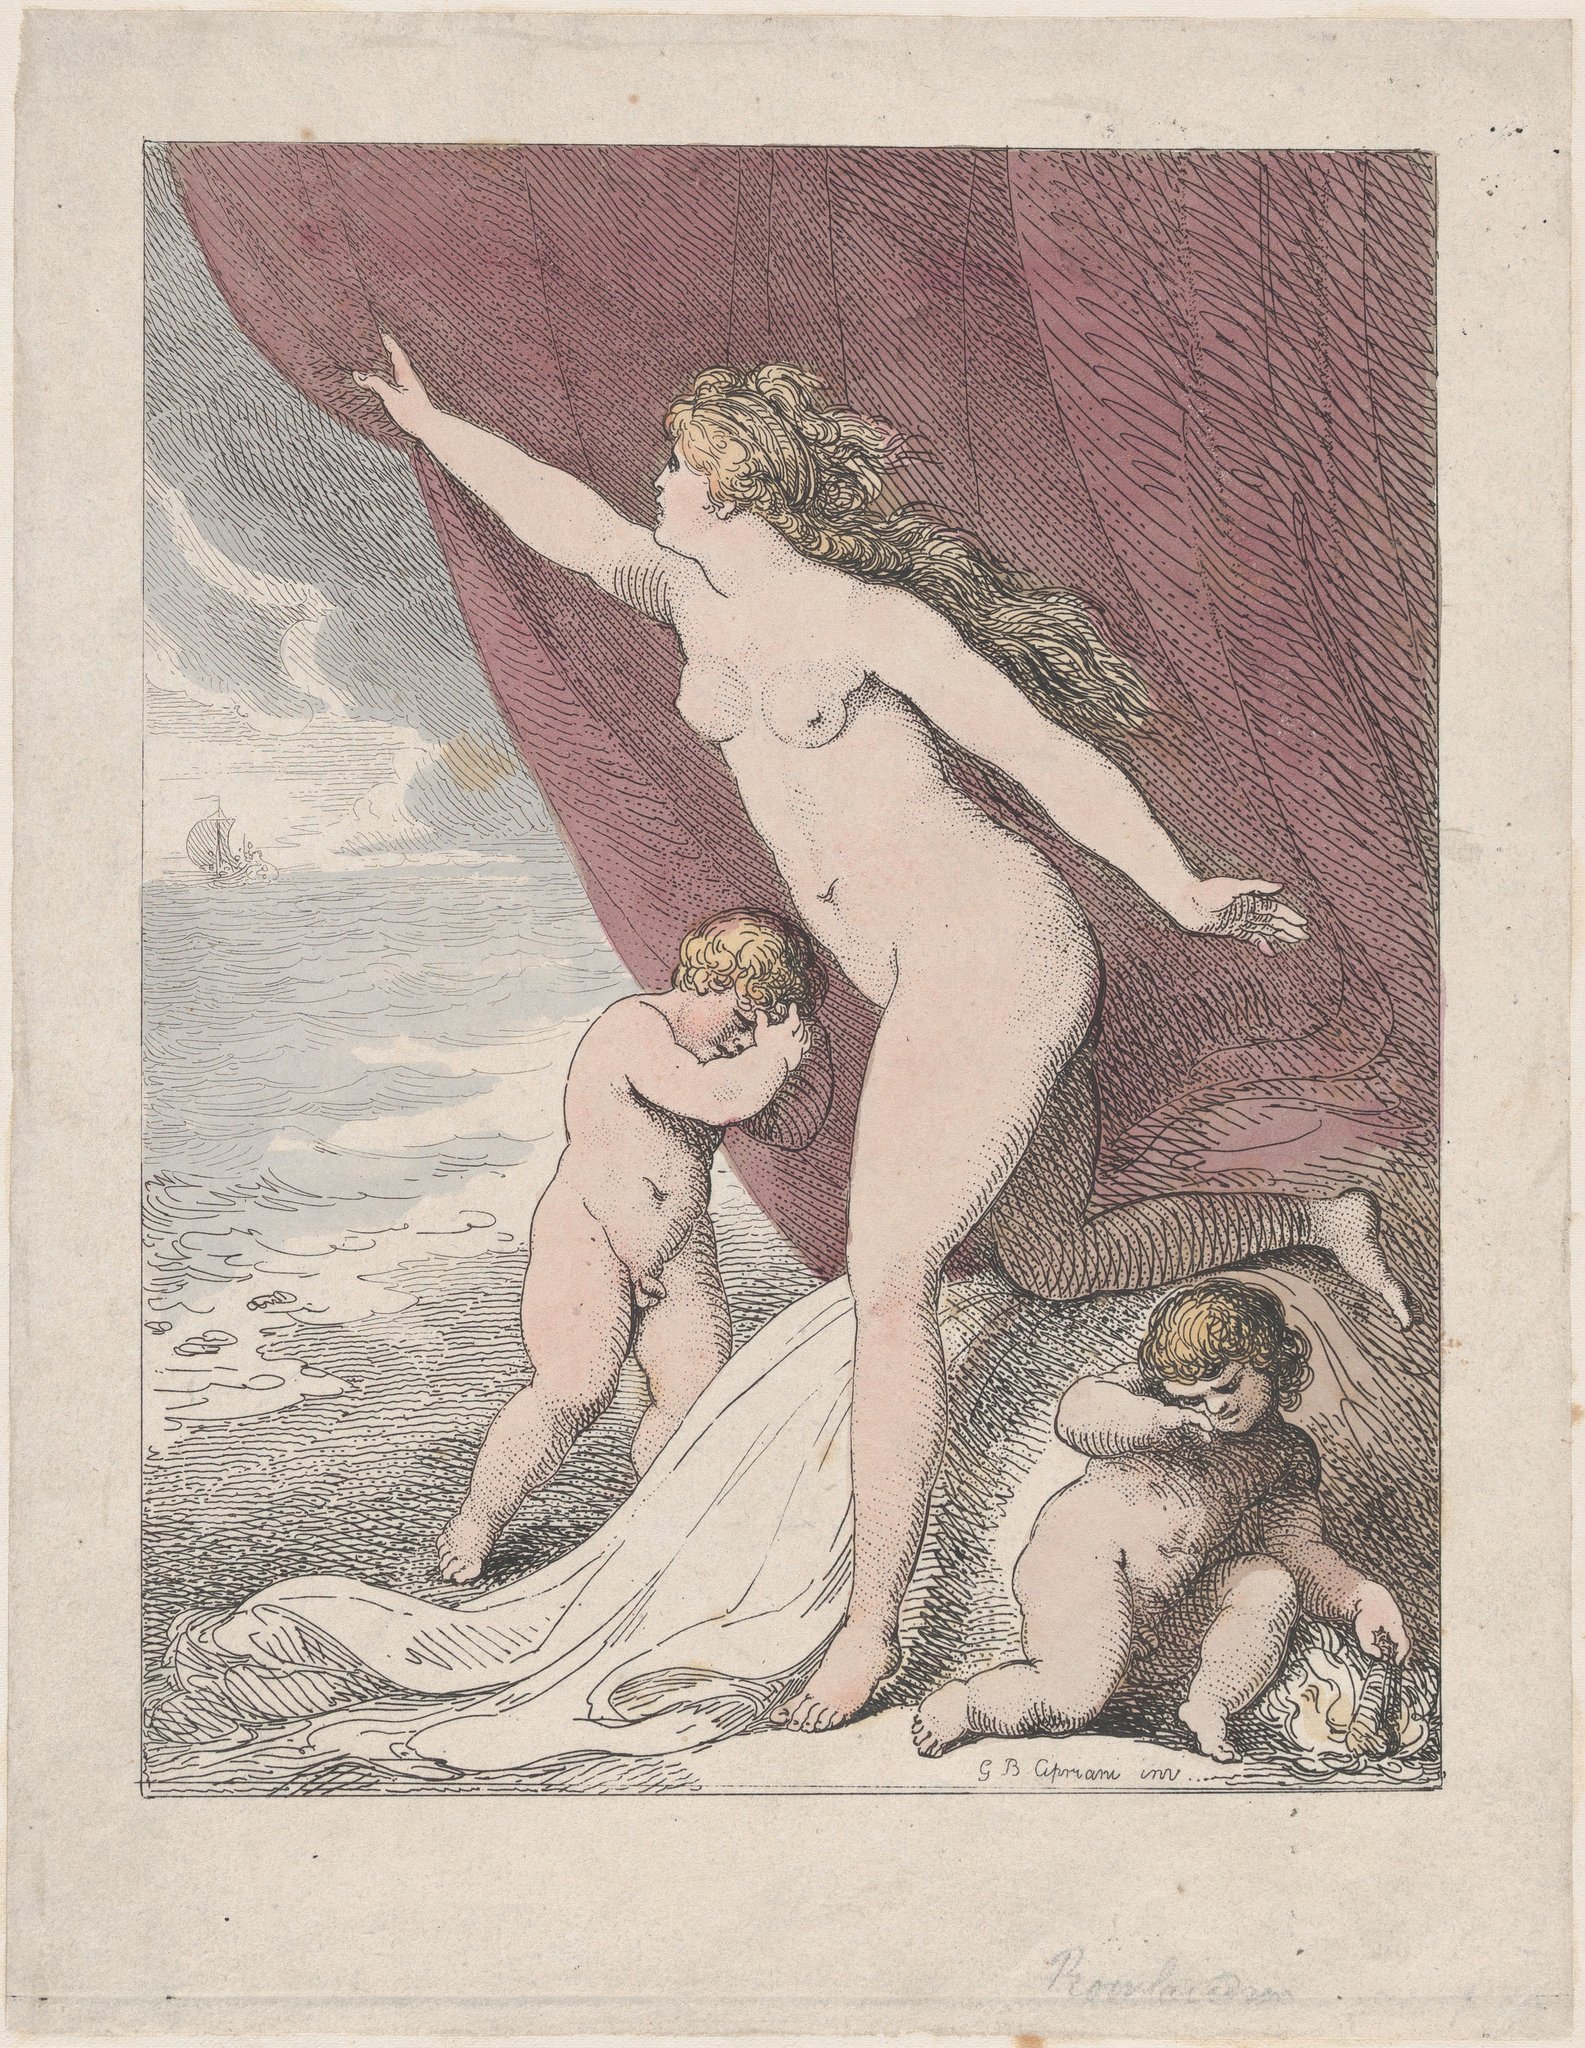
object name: print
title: Ariadne Abandoned by Theseus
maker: thomas rowlandson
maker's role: artist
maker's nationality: british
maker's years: 1757-1827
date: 1790-1799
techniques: etching, hand coloring, stippling